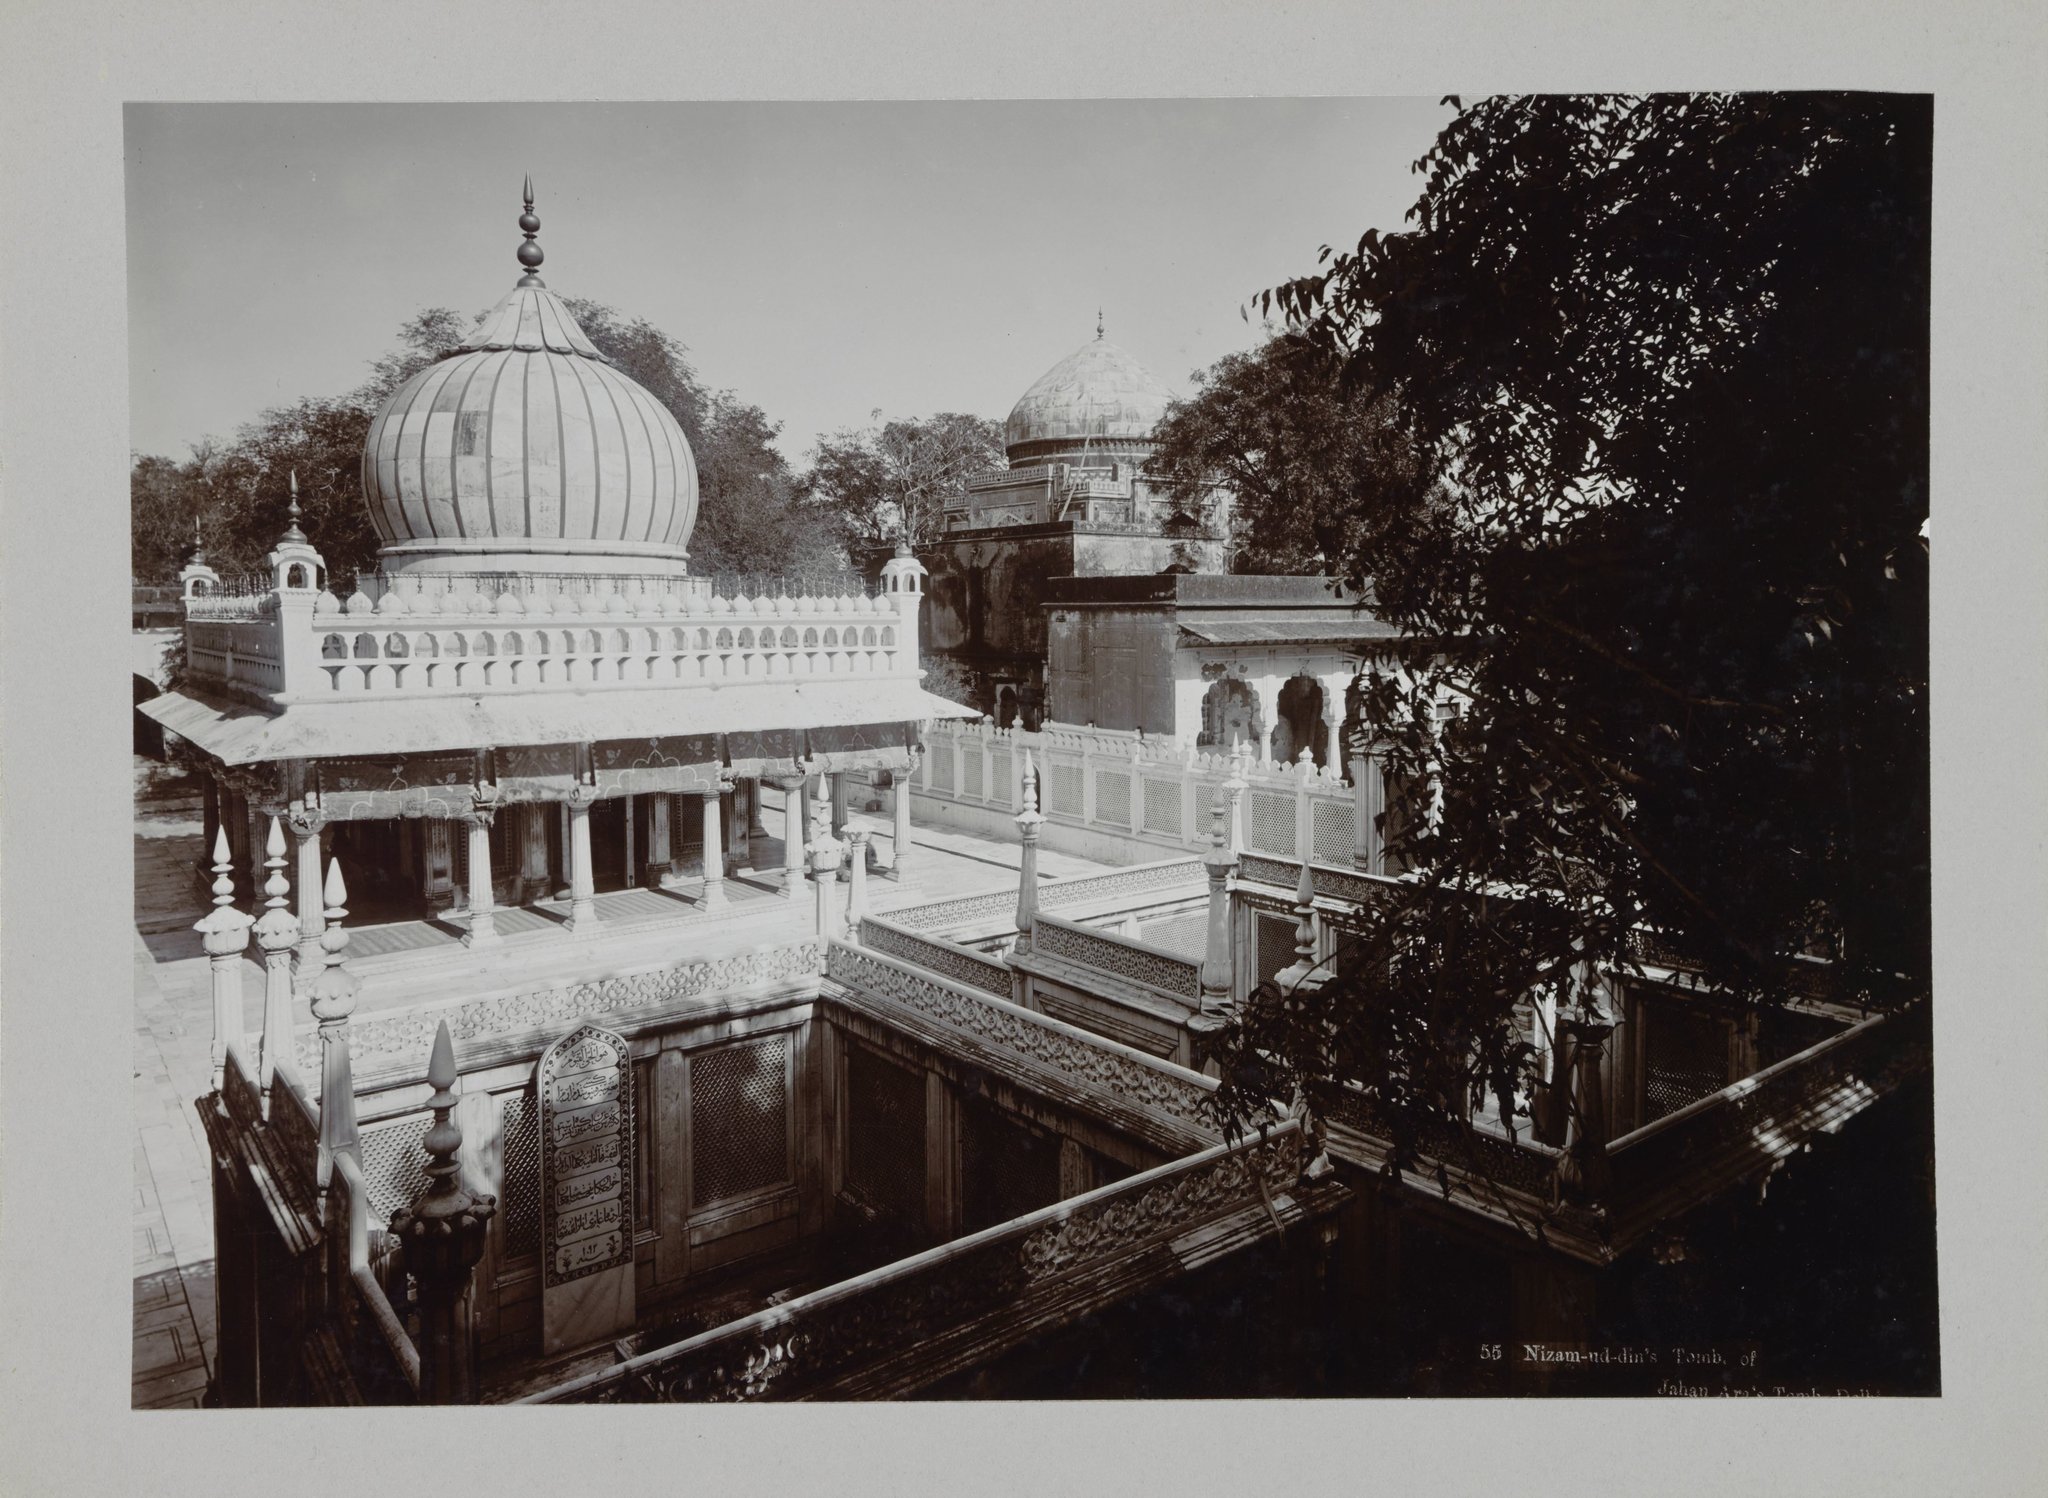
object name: photograph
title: Nizamuddin's Tomb, Delhi, India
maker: Anonymous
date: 1895-1915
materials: cardboard, paper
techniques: gelatin silver print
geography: delhi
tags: delhi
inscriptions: inscription: ‘55 Nizam-ud-din's Tomb, of Jahan Ara's Tomb, Delhi’, annotation: ‘37. Graf v/e profeet in eene der oude Delhi's.’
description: Titel '55 Nizam-ud-din's Tomb, of Jahan Ara's Tomb Delhi' is gedeeltelijk van de foto afgesneden.